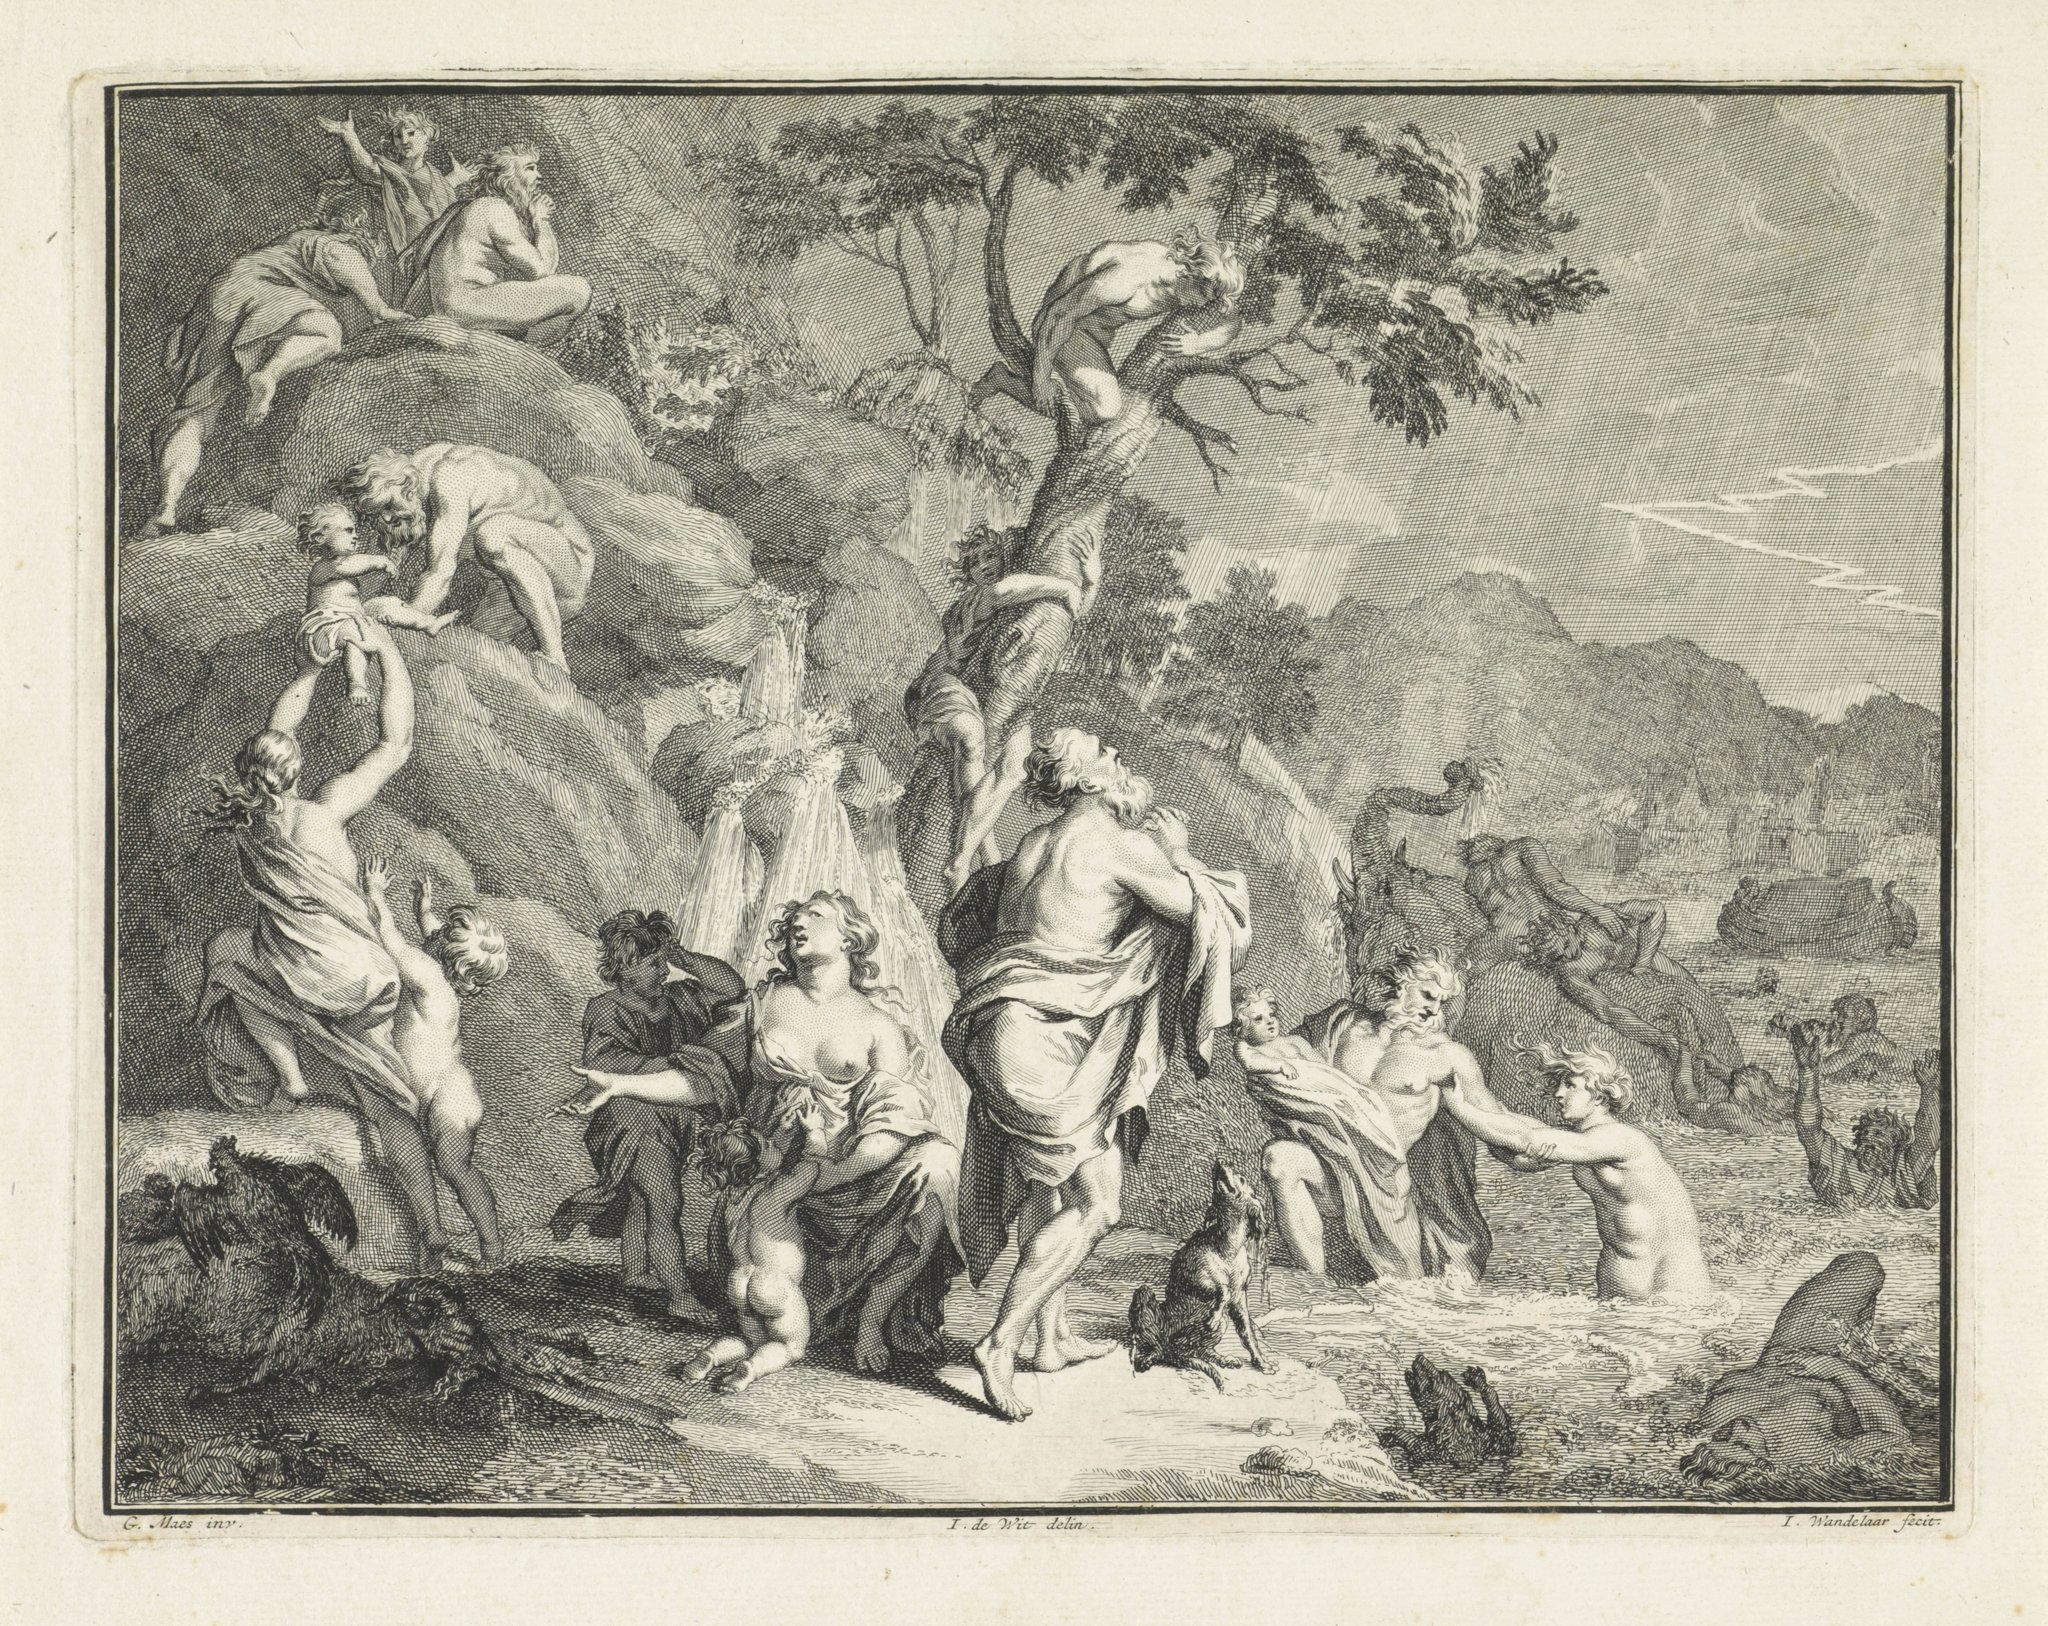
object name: print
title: Zondvloed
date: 1710-1759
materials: paper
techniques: engraving, etching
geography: amsterdam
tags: the flood and destruction of mankind ~ story of noah (genesis 7:10 - 8:17)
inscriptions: collector's mark: Lugt 240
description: De Zondvloed overstroomt de aarde. Mensen en dieren proberen zichzelf en anderen in veiligheid te brengen door naar hoger gelegen gebieden te vluchten. In de verte is de ark van Noach weergegeven.